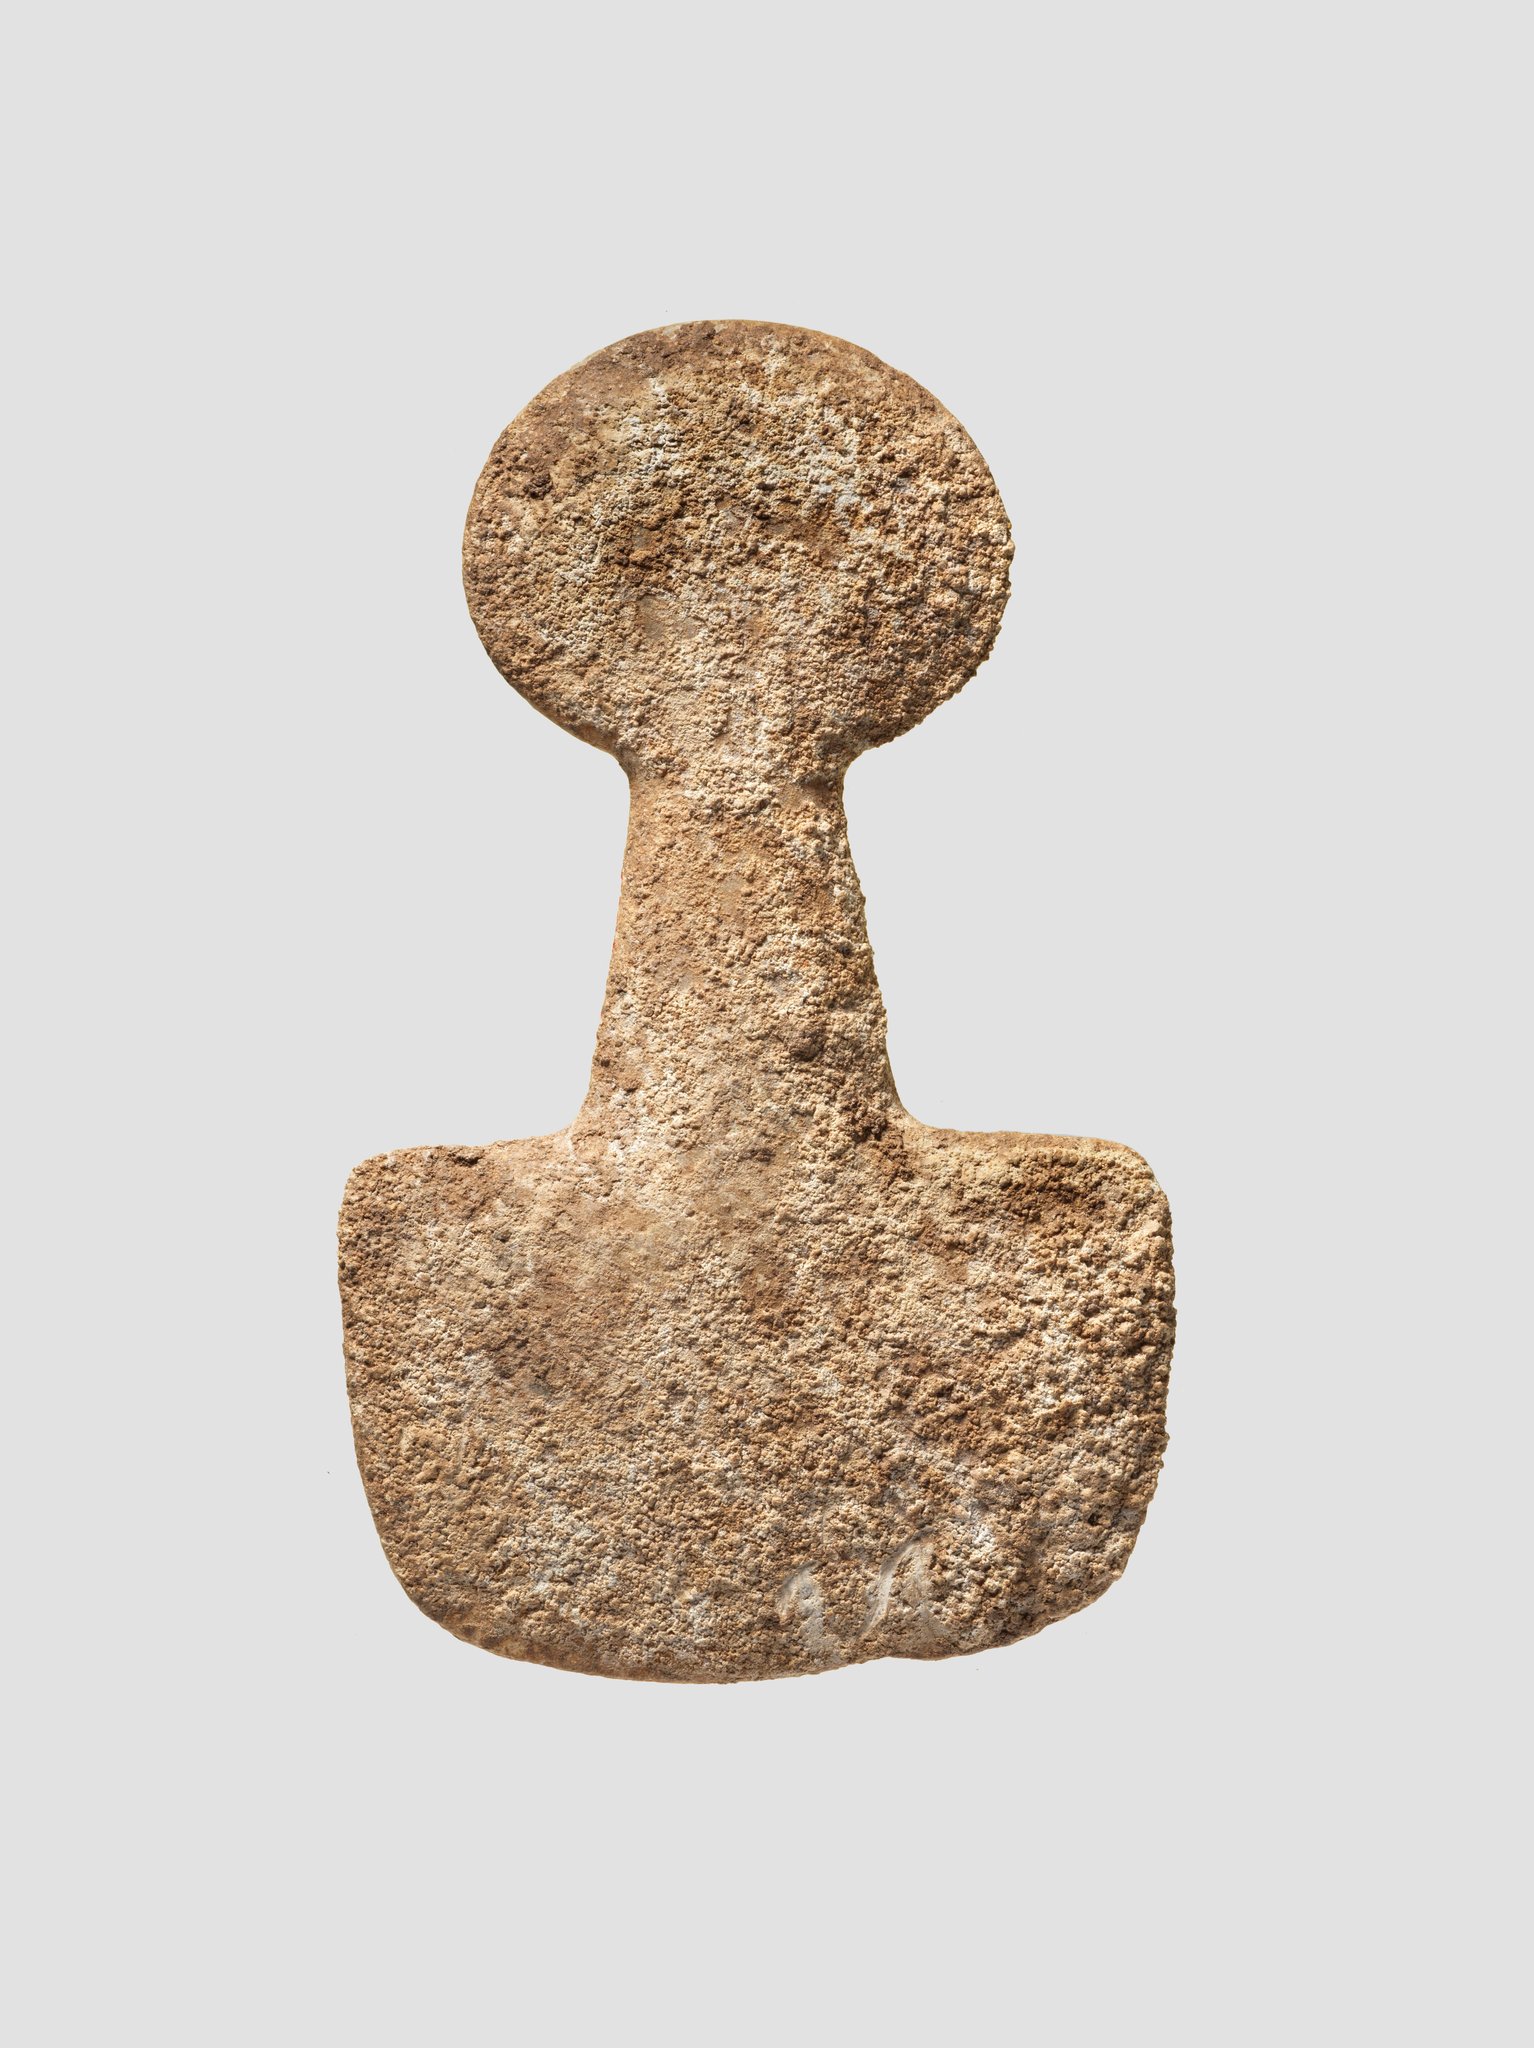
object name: sculpture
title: Spade-shaped schematic female (?) figure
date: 3000-2800 BCE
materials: limestone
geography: anatolia